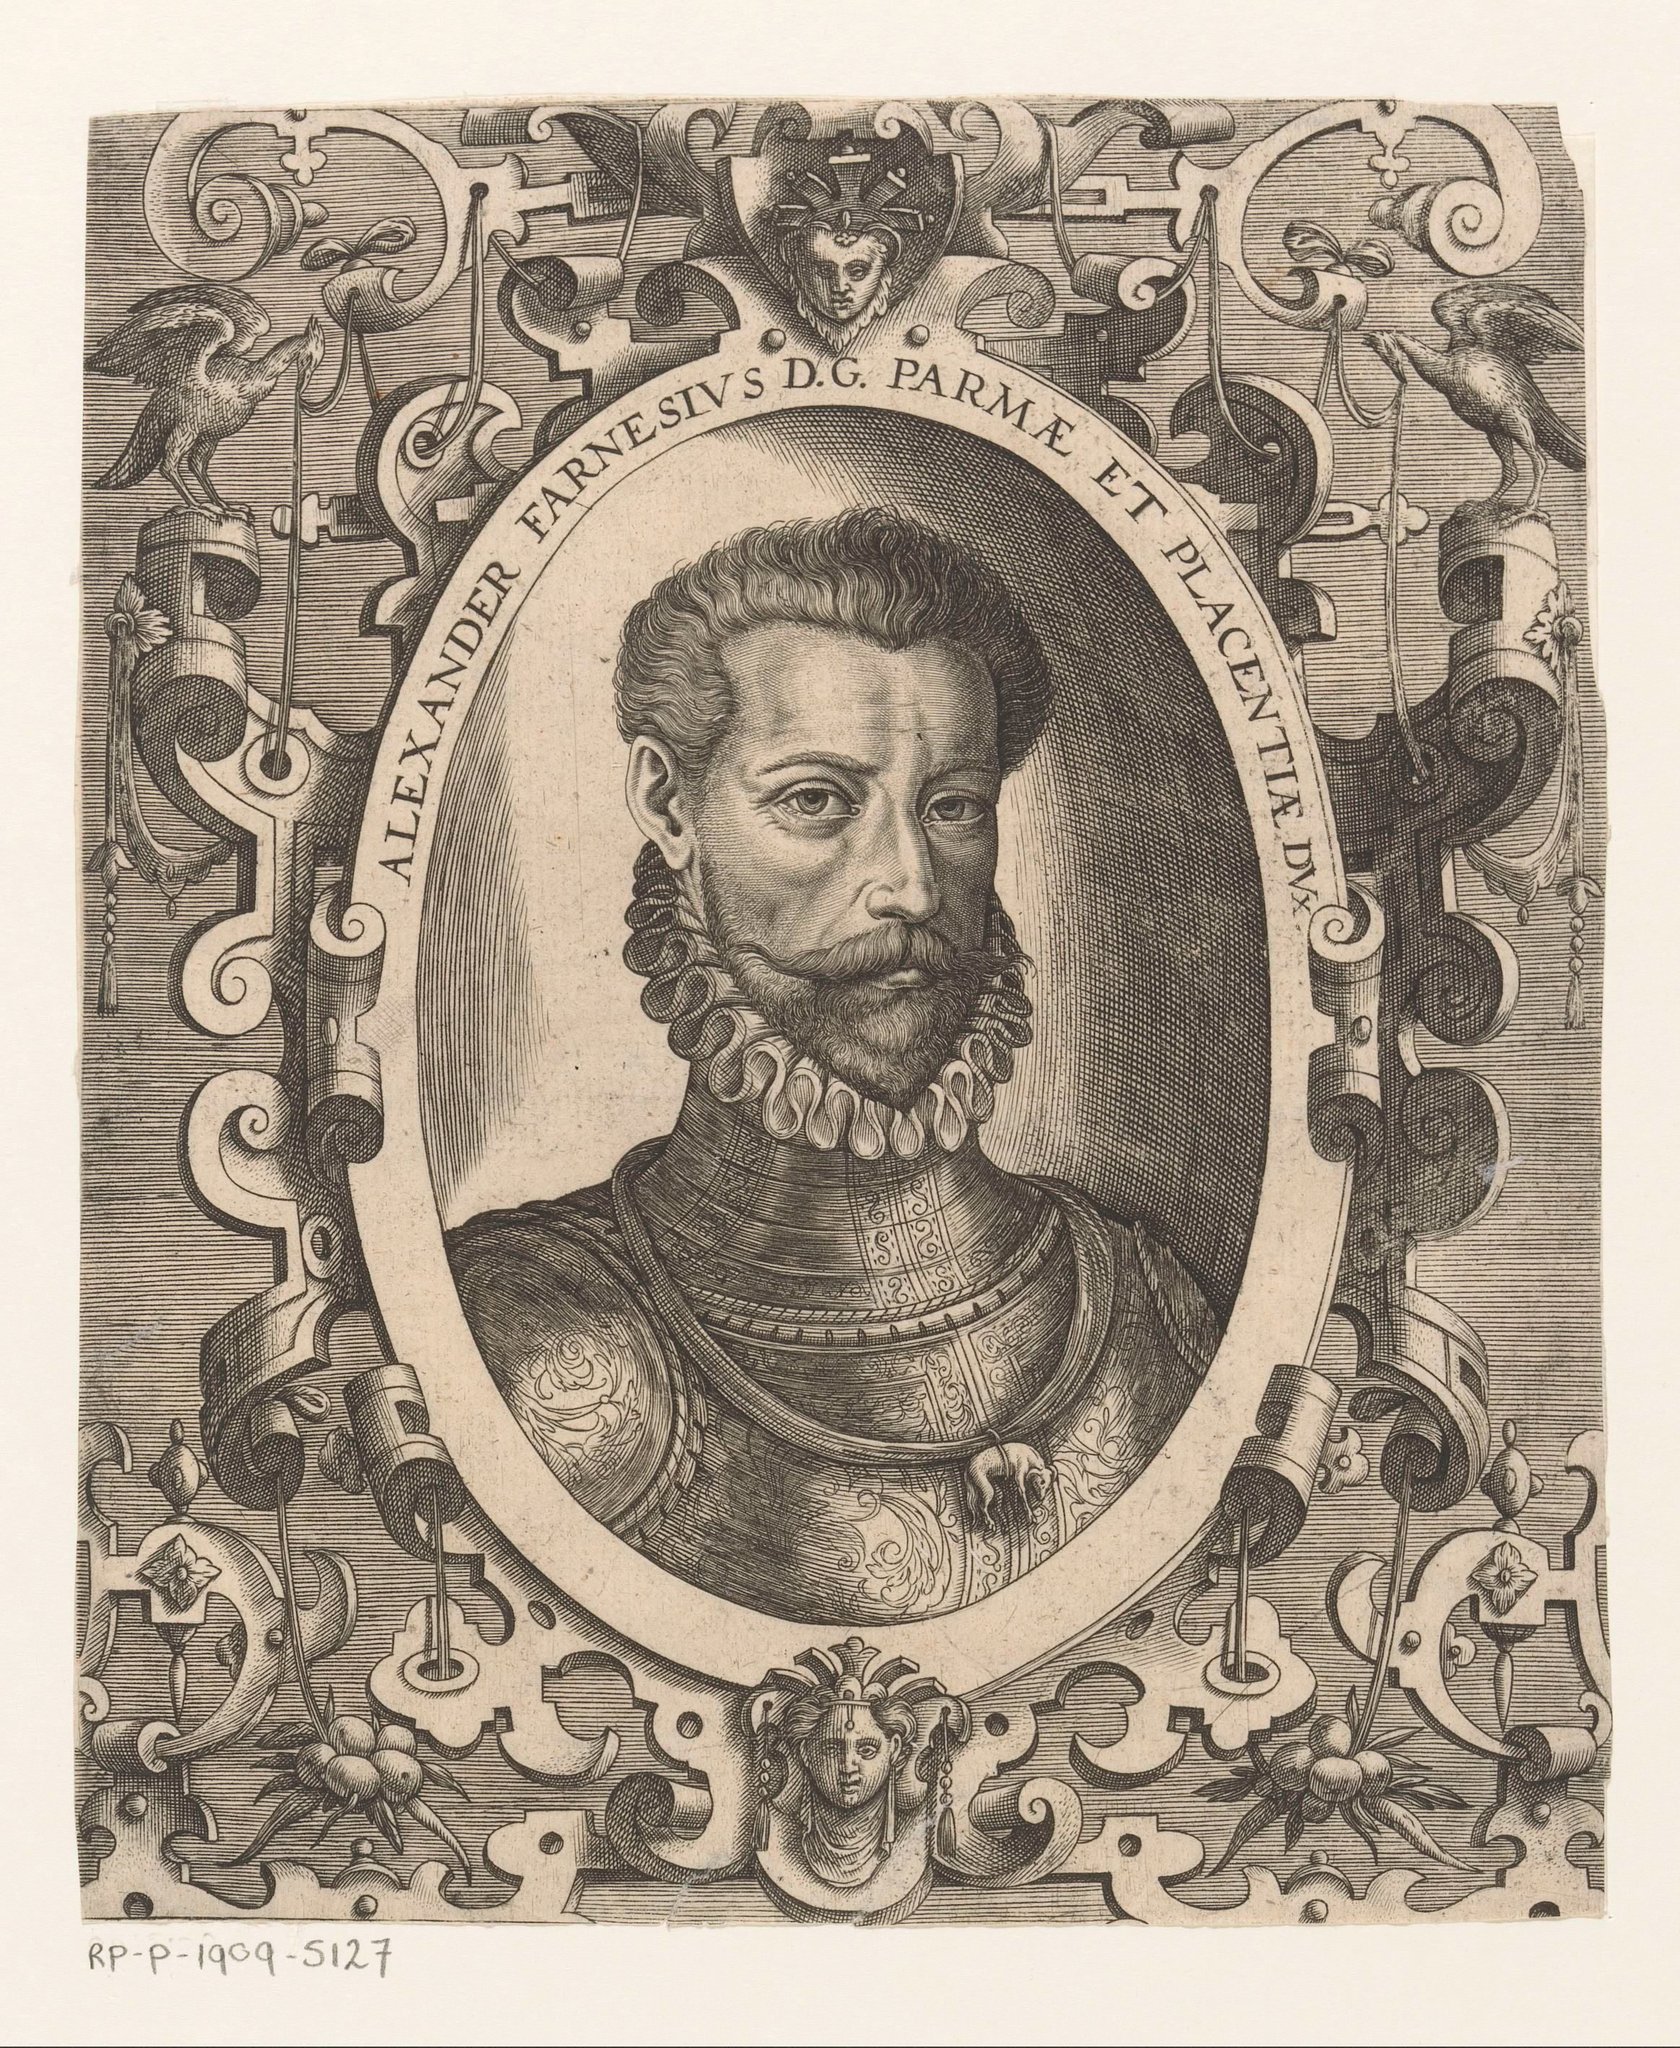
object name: print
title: Portret van Alexander Farnese, hertog van Parma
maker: niccolò nelli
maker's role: print maker, publisher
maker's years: 1535-1585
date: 1569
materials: paper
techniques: engraving, etching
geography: venice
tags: rome, alessandro farnese (landvoogd van de nederlanden en hertog van parma en piacenza), ornament derived from animal forms, fruits and vegetables ~ ornament, historical persons, knighthood order of the golden fleece - insignia of a knighthood order, e.g.: badge, chain (with name of order)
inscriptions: collector's mark: Lugt 2228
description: Prent uit een serie portretten van onbekende omvang getiteld 'Imagines Quorundam Principum et Illustrium Virorum' met prenten door Niccolò Nelli, Domenico Zenoi, Martino Rota, Nicolas Bèatrizet en Cornelis Cort, uitgegeven in 1569 te Venetië.